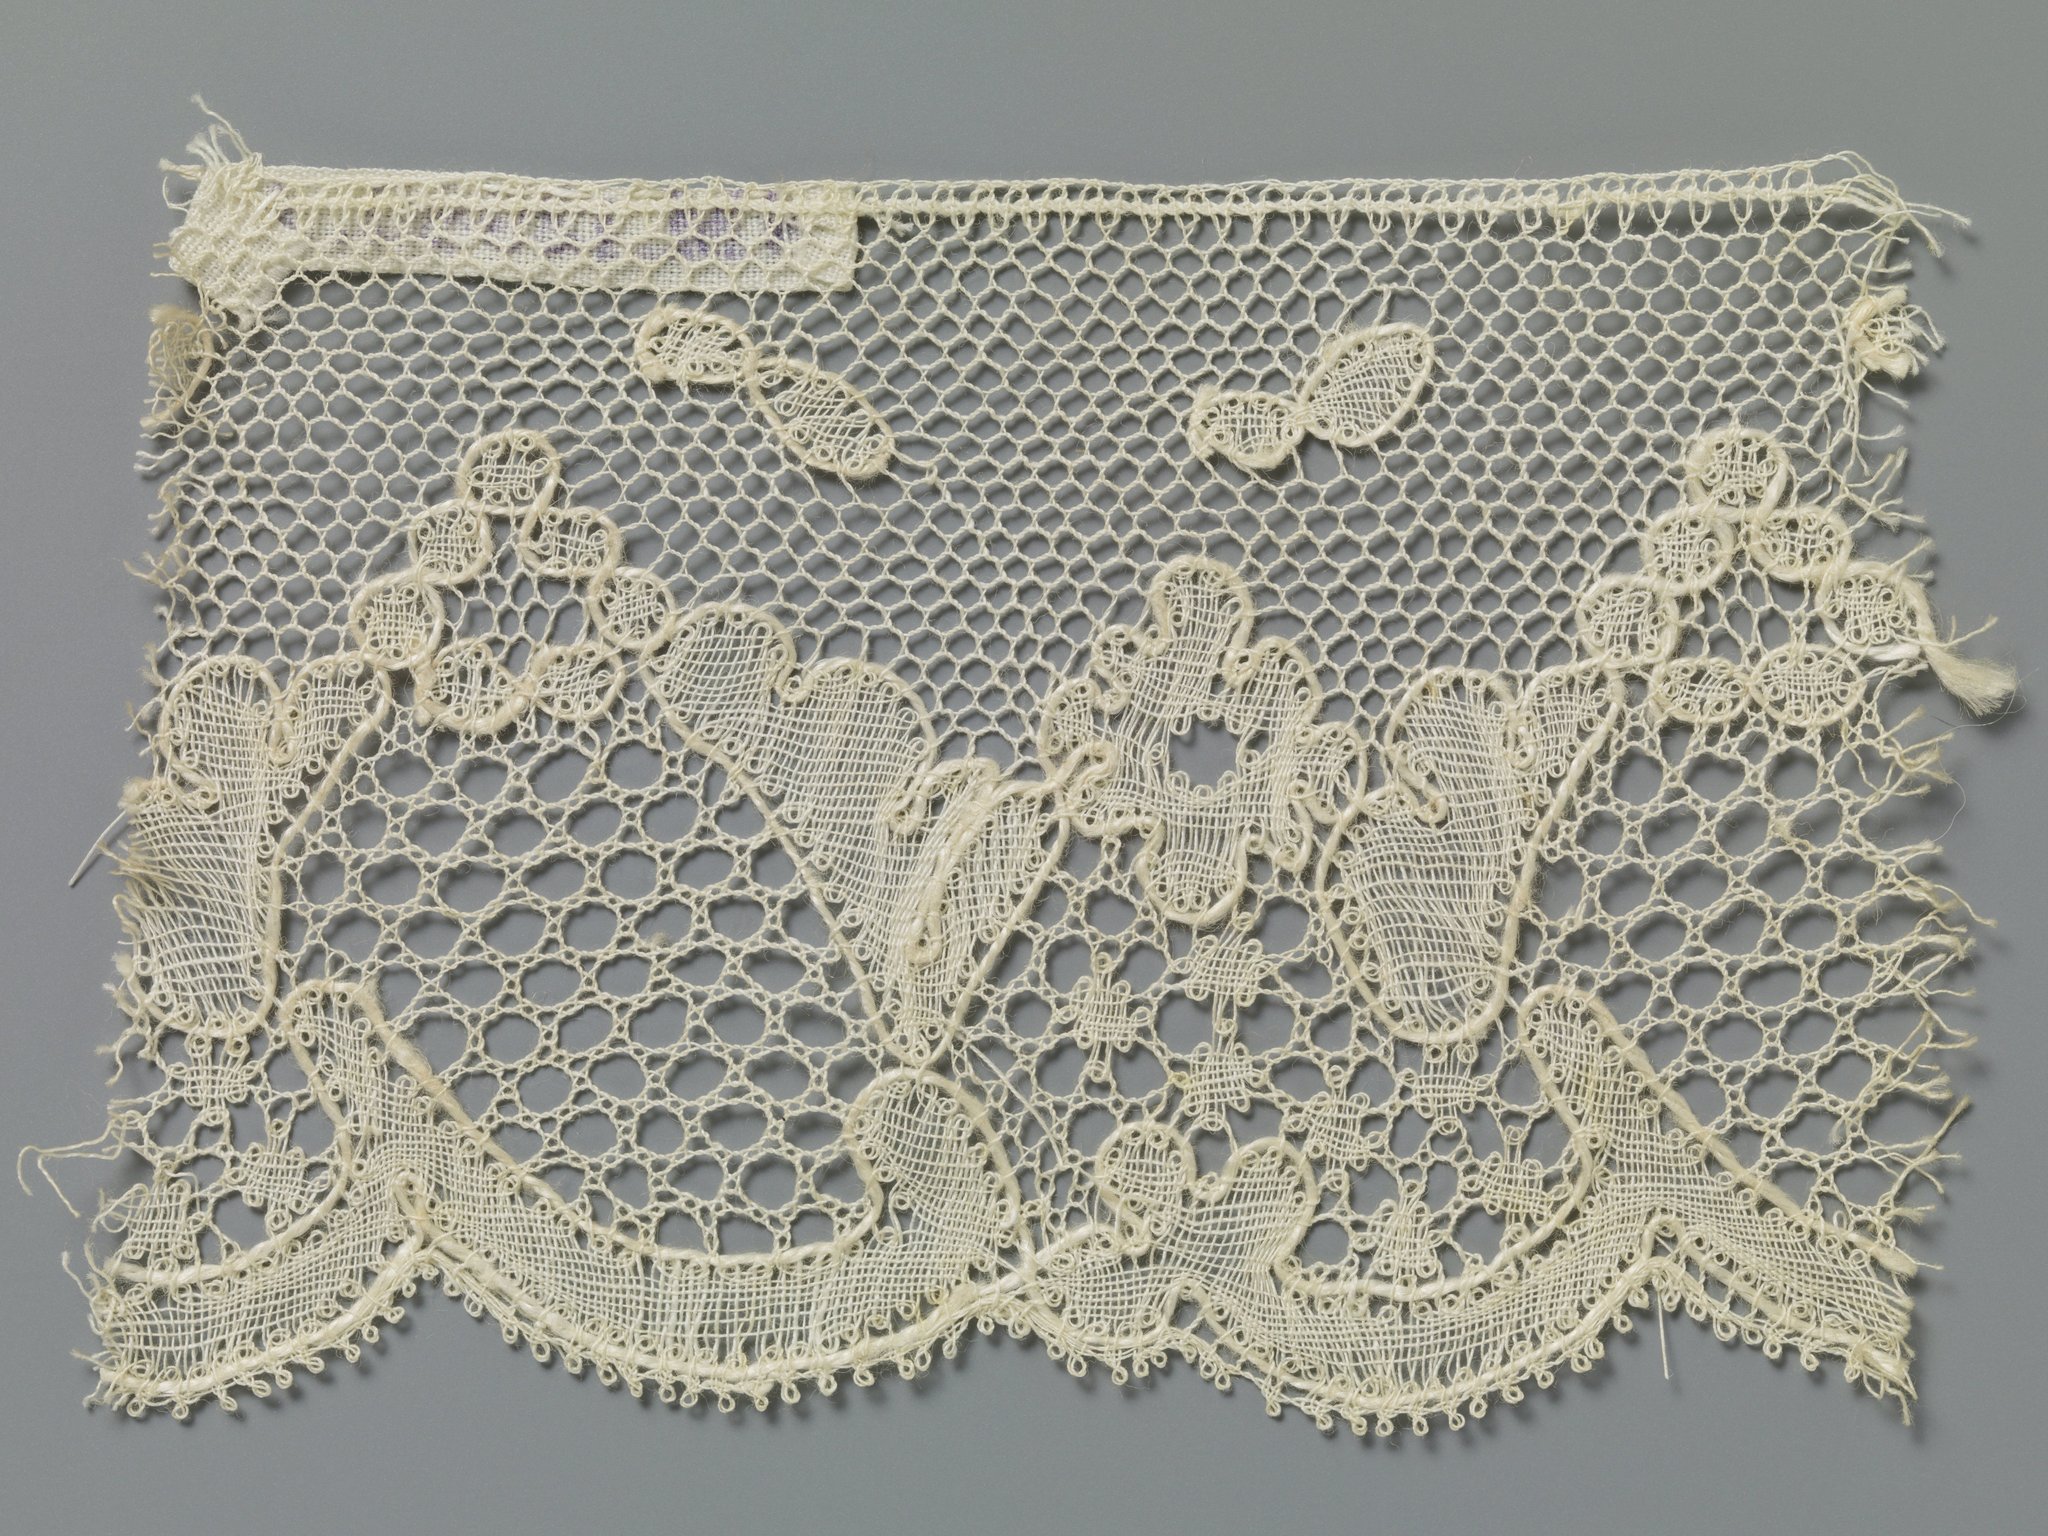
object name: strip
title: Strook kloskant met aaneengeschakelde cartouches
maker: Anonymous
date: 1800-1899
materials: cotton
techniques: lace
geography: buckingham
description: Strook naturelkleurige kloskant, Buckingham-kant. Het zich herhalende patroon bestaat uit aaneengeschakelde a-symmetrische cartouches, afwisselend een kleinere bekroond door een rozetbloem en een grotere bekroond door een driehoek gemaakt met zeven cirkeltjes. De motieven zijn aan de bovenkant met elkaar verbonden door een maasgrond, een tulegrond. De motieven zijn gemaakt in linnenslag en voorzien van dikke en glimmende contourdraden. Het hart van de rozetbloem is uitgespaard. Als siergrond is een rozengrond toegepast in de cartouches, waarbij in de kleine cartouche tevens sneeuwvlokken zijn verwerkt, deze zijn niet voorzien van contourdraden. De bovenzijde van de strook is recht afgewerkt. De schulpenrand langs de onderzijde komt volgt de onderzijde van de cartouches en is afgewerkt met picots.